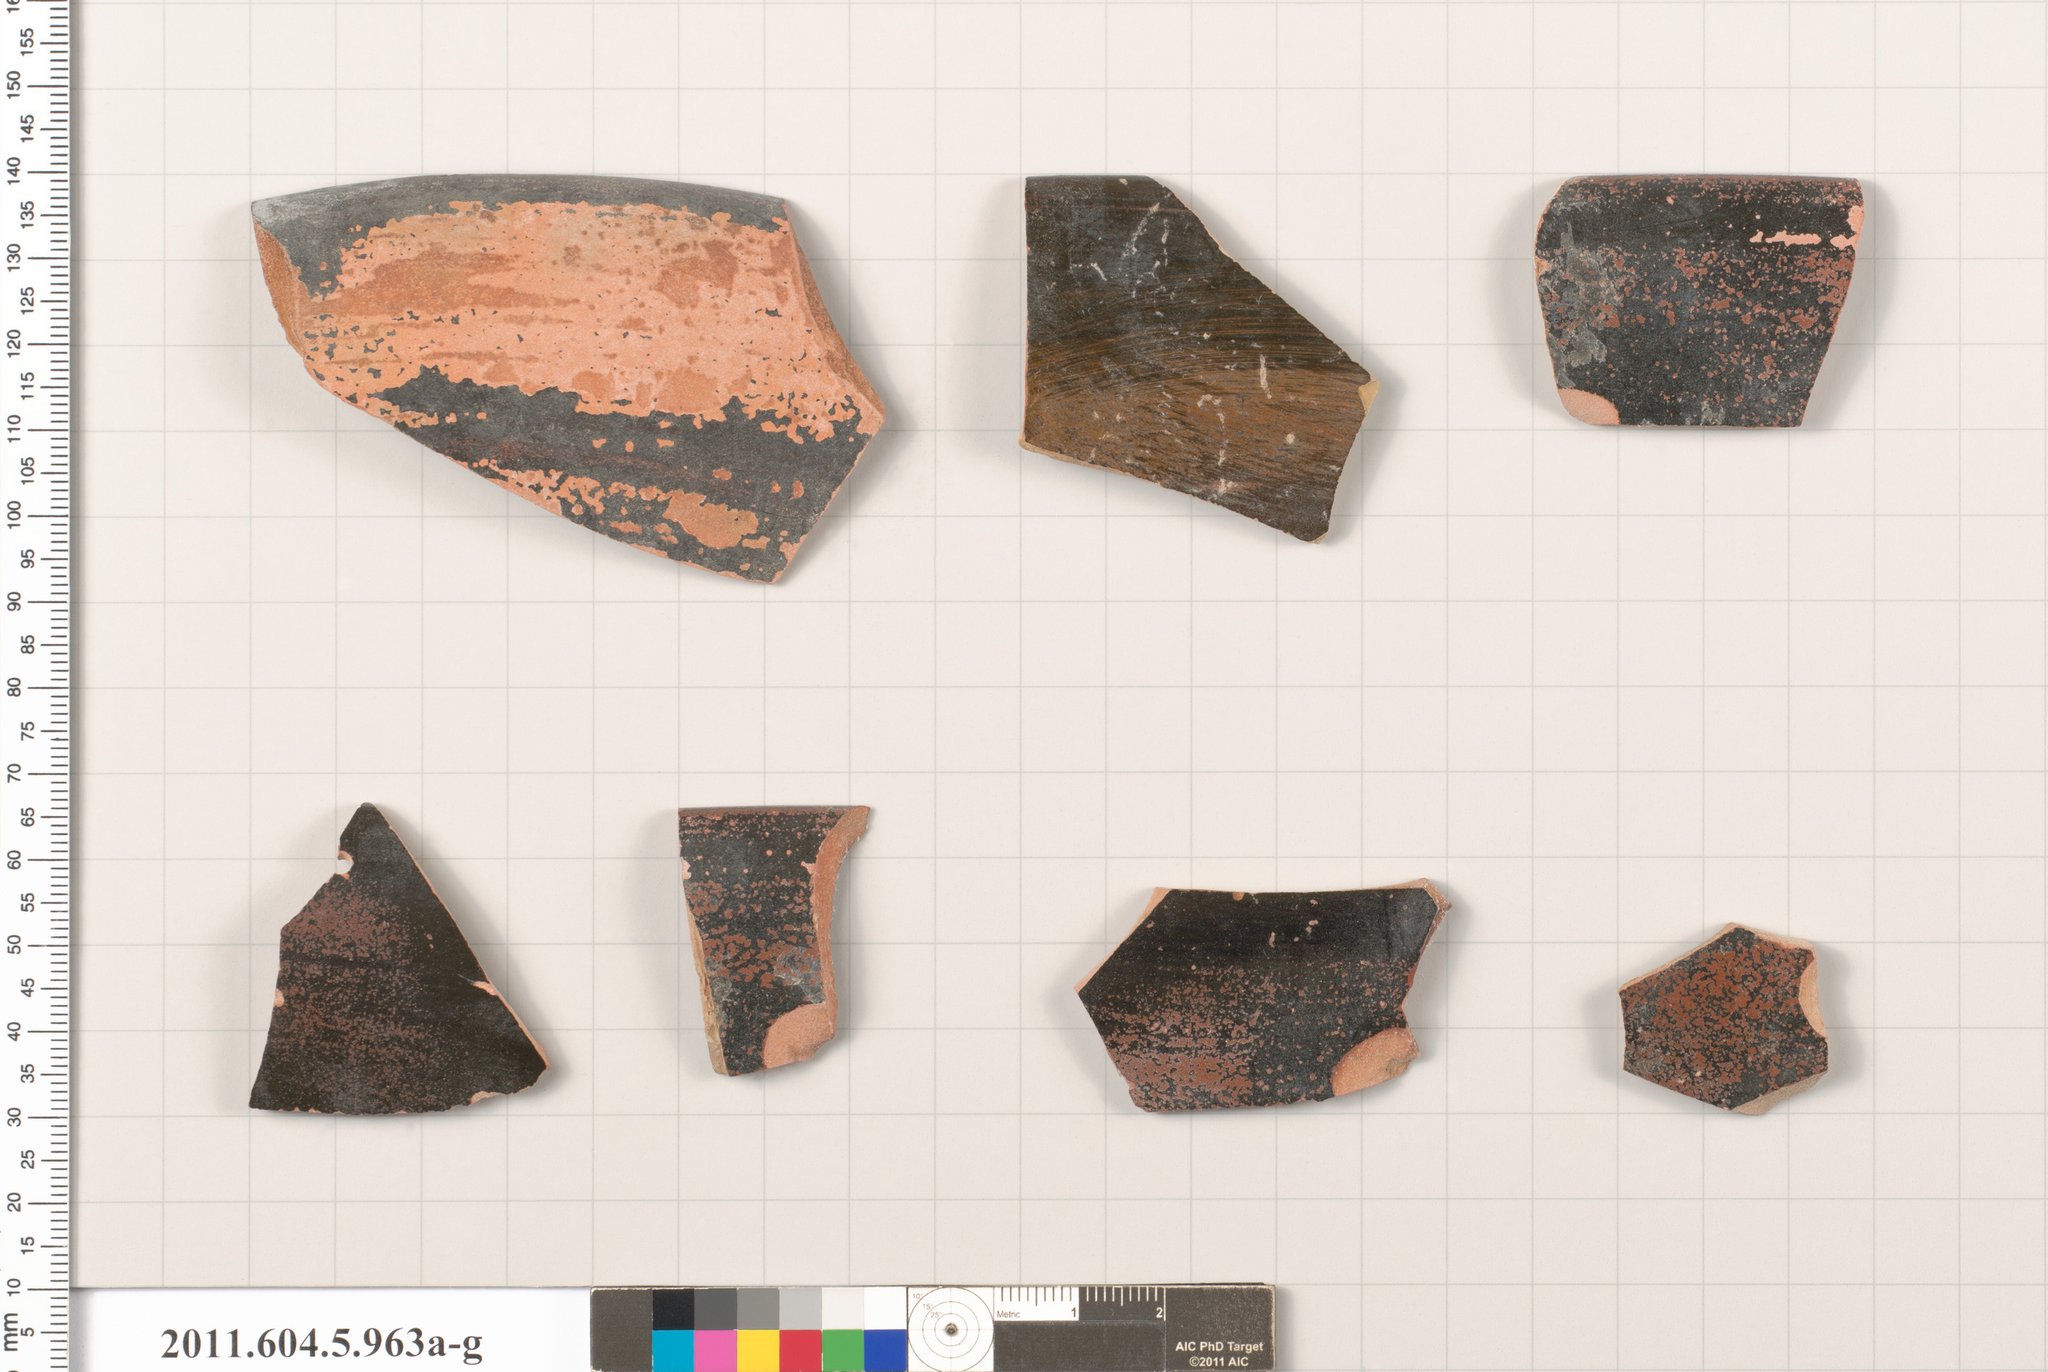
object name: kylix fragment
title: Terracotta fragments of a kylix (drinking cup)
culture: greek, attic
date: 600-401 BCE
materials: terracotta